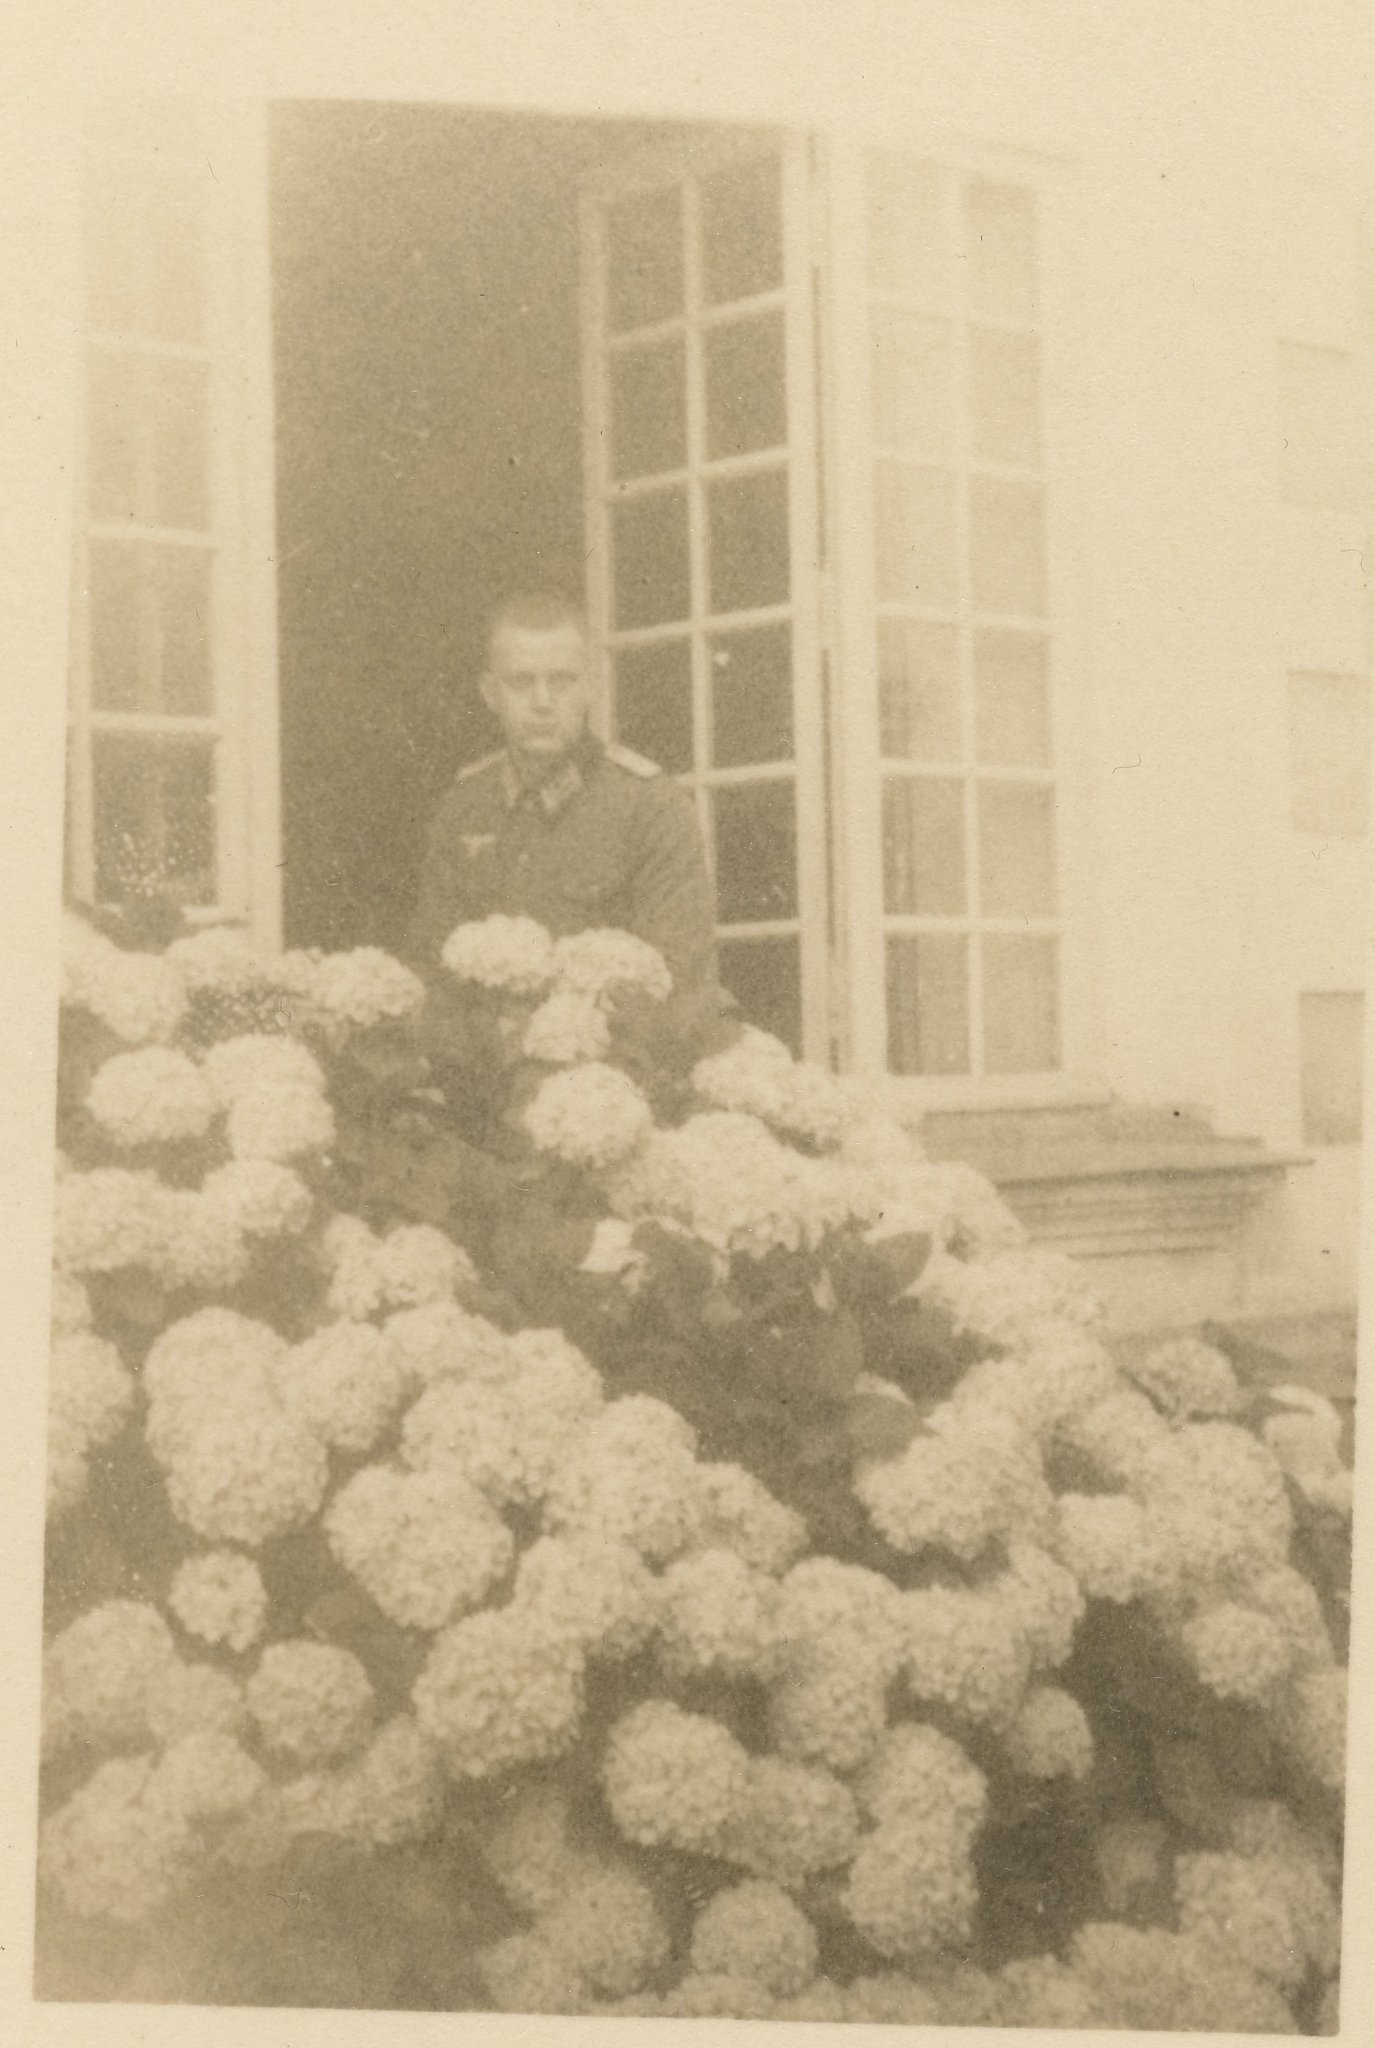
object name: photograph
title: Een soldaat in deuropening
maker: Anonymous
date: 1940-1945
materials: photographic support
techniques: gelatin silver print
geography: czechoslovakia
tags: netherlands, germany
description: Een soldaat staat in een open deur achter een bloeiende Hortensia. Foto behorend bij album 'Kriegserinnerungen'.